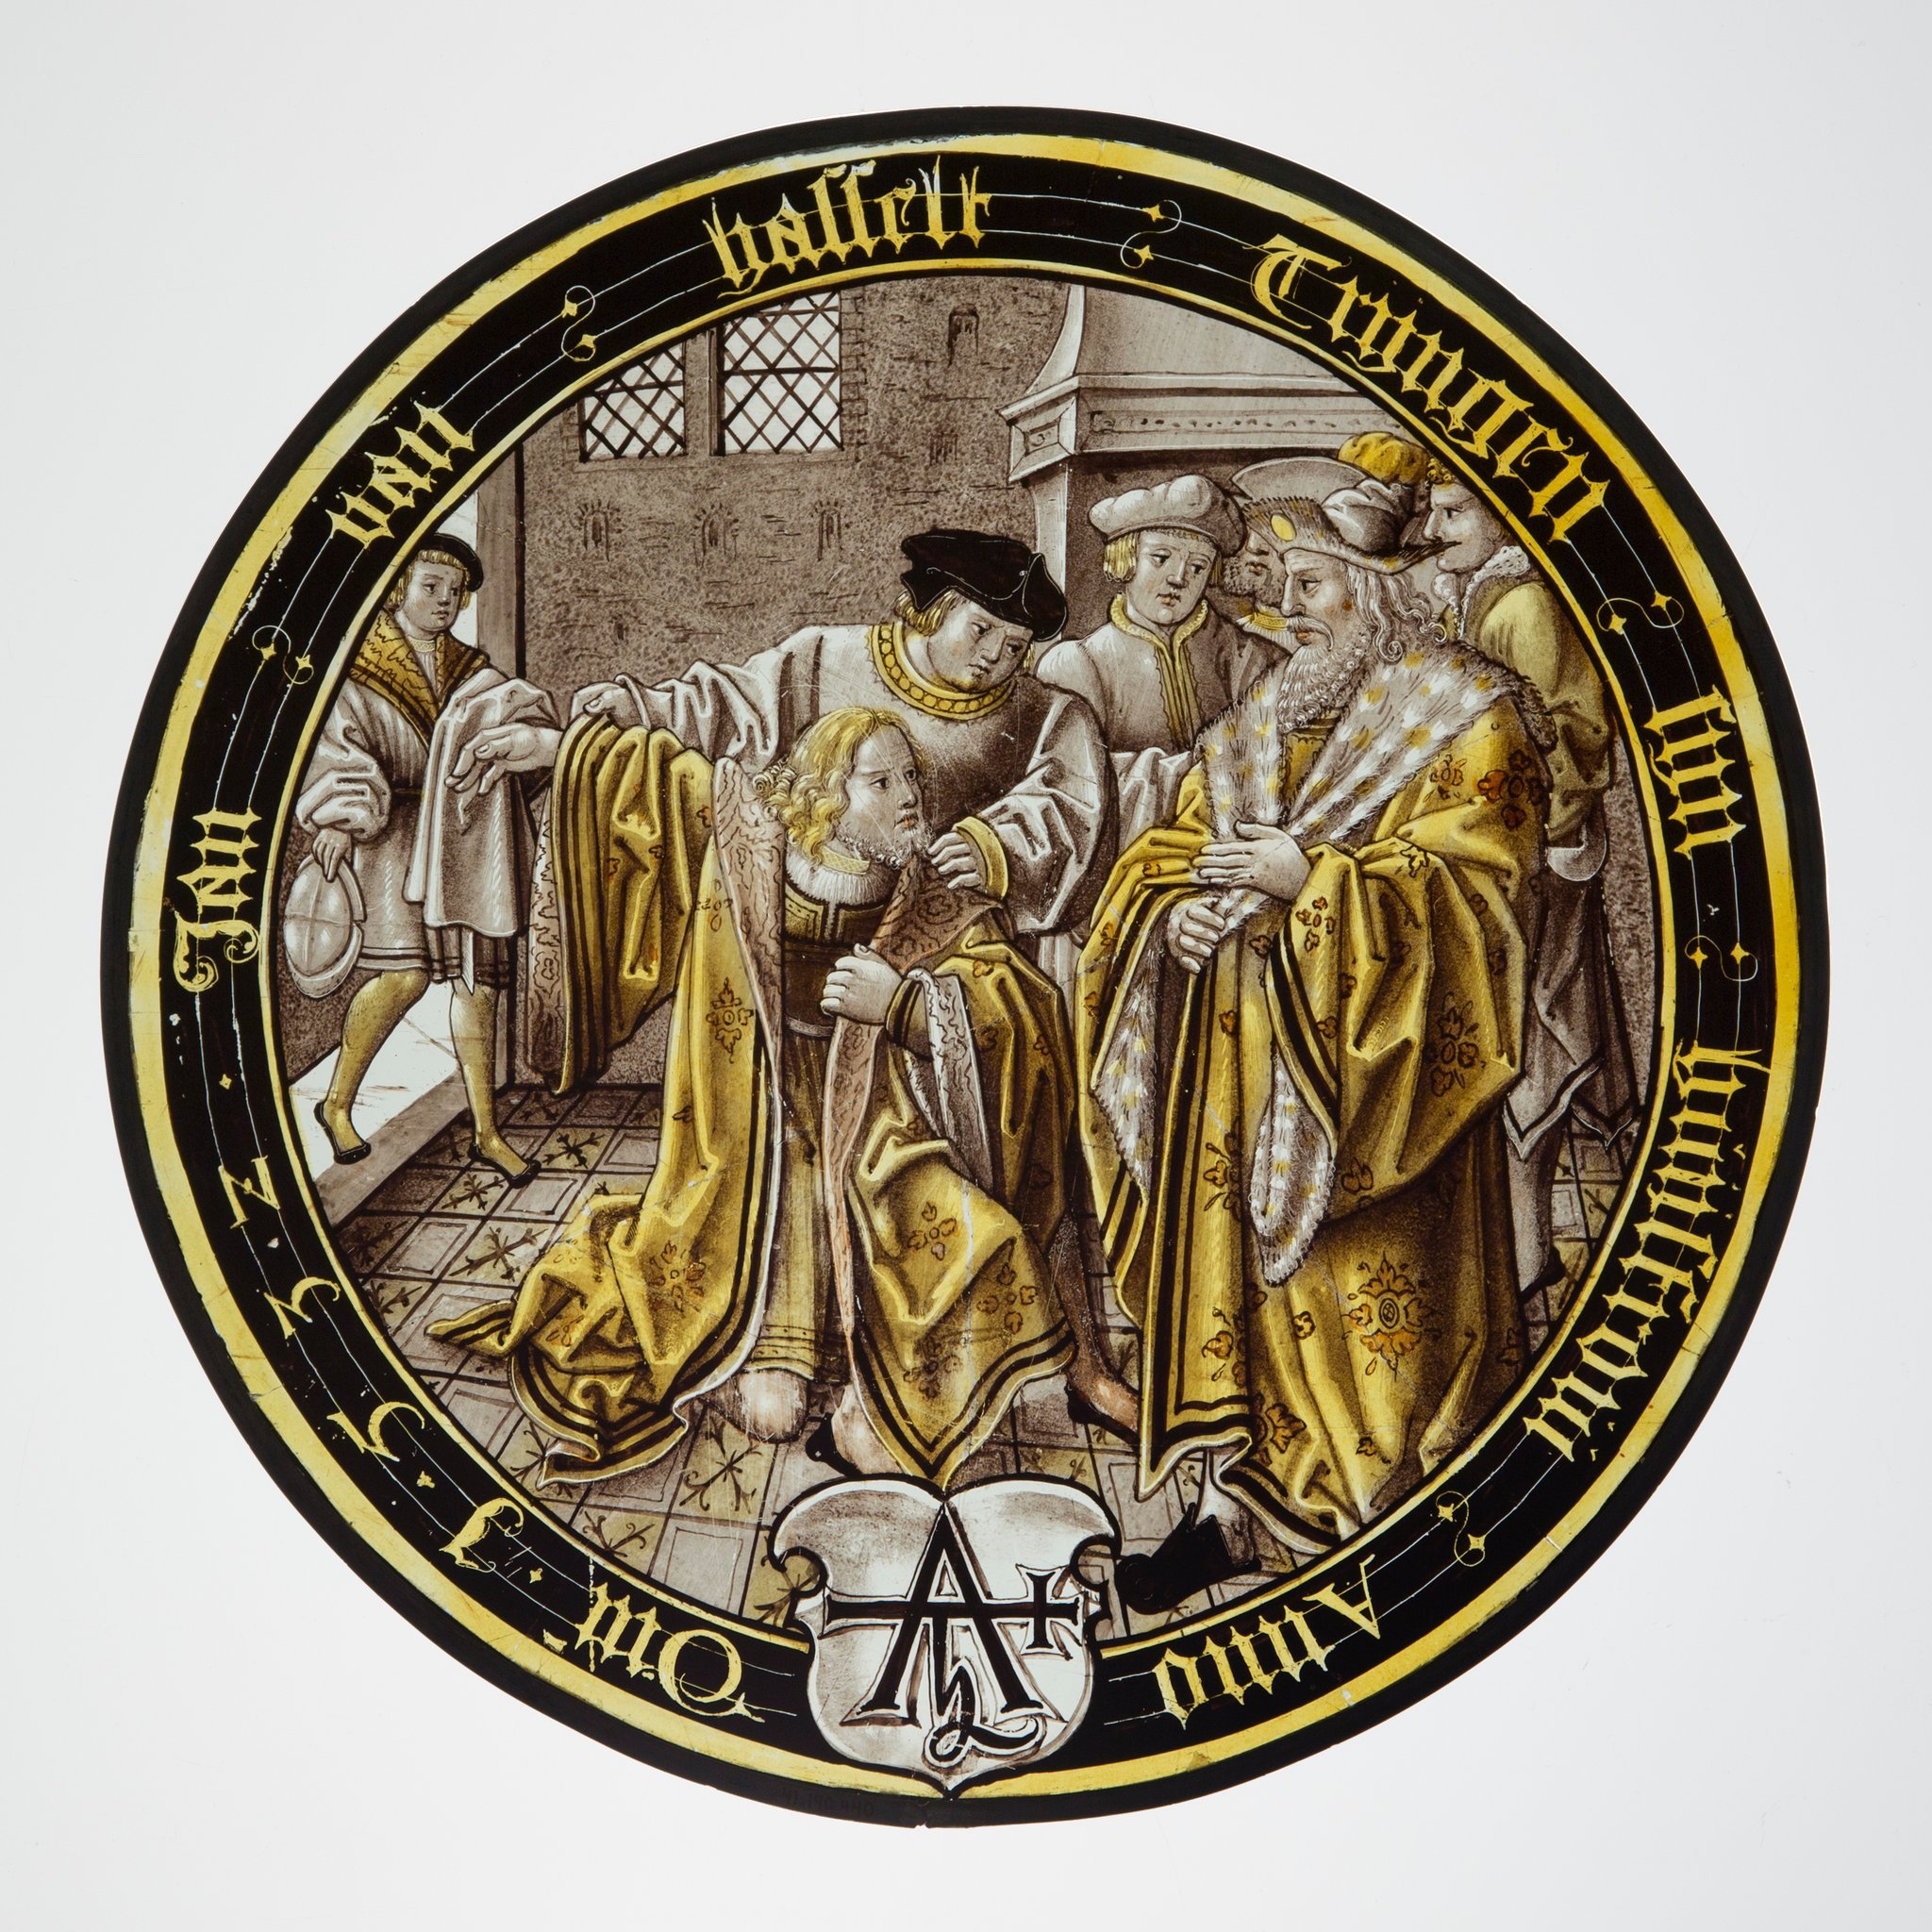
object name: roundel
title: The Prodigal is Given the Best Coat (one of eight scenes from the story of the Prodigal Son)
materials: glass, paint, pigment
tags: men,coat of arms